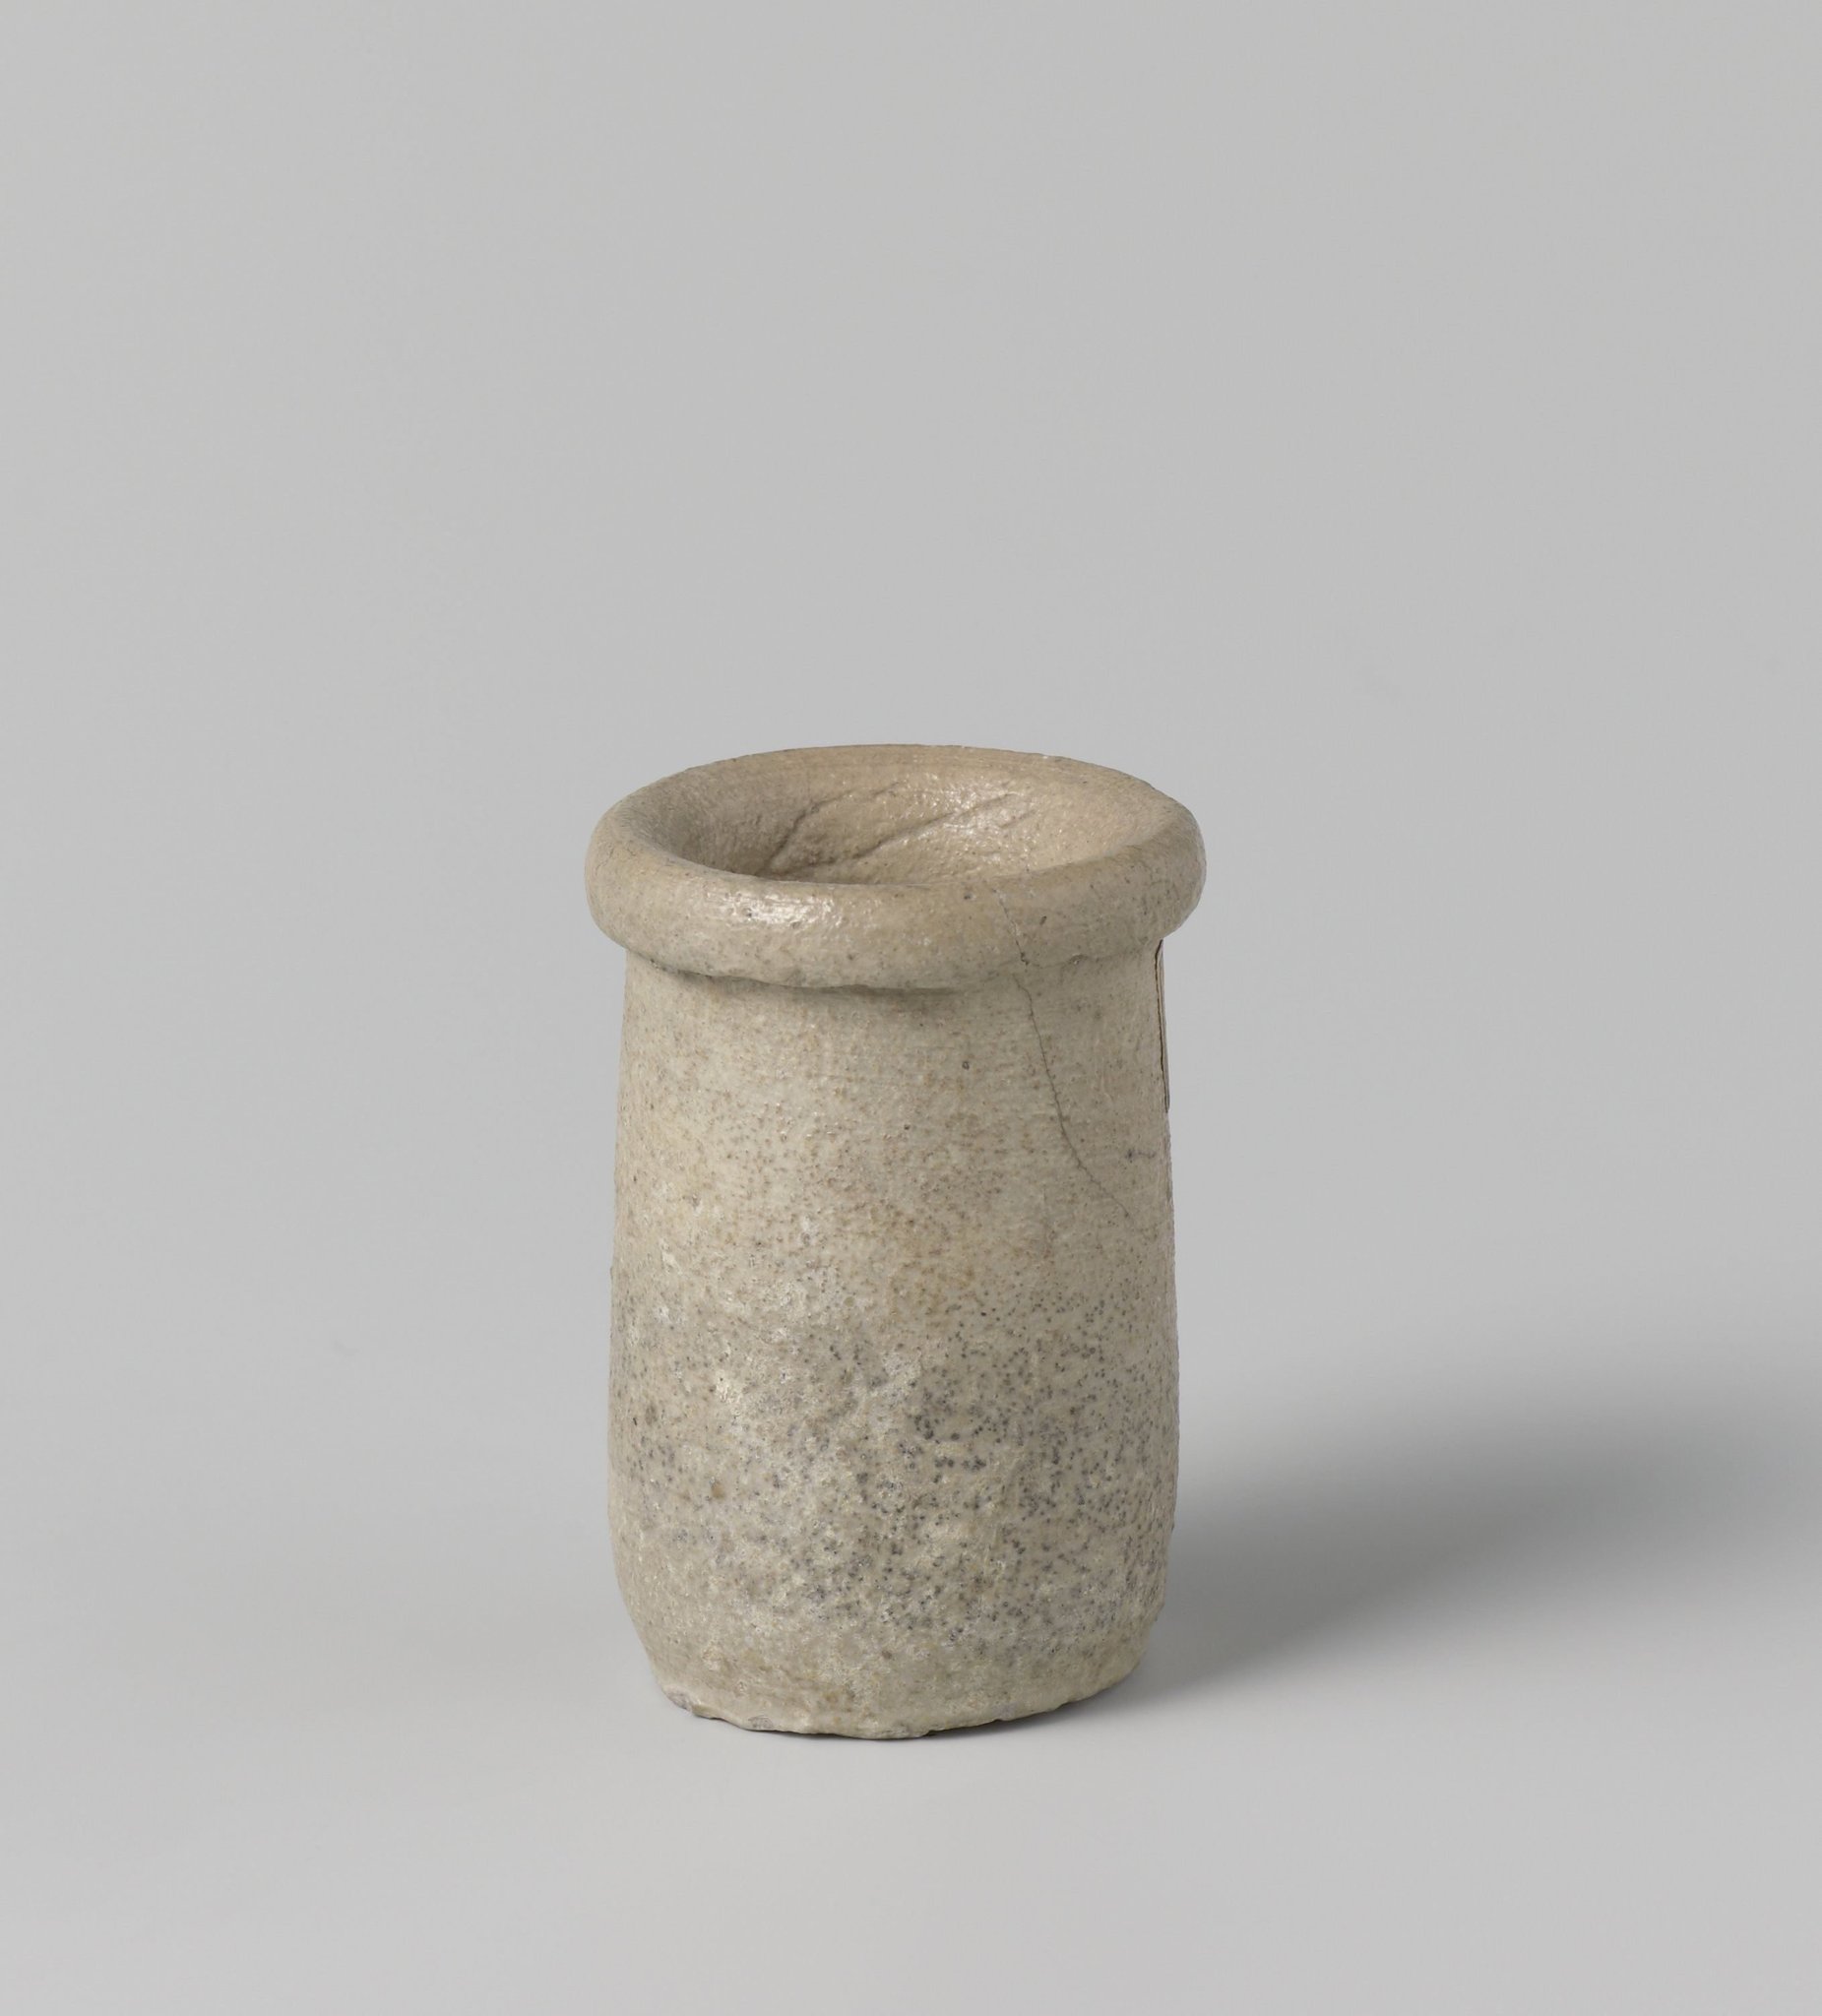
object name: pot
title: Cylindrical jar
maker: Anonymous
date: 1600-1699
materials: glaze, stoneware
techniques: firing, turning, vitrification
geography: germany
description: Kleine, cilindrische pot van steengoed met een iets spreidende rand.